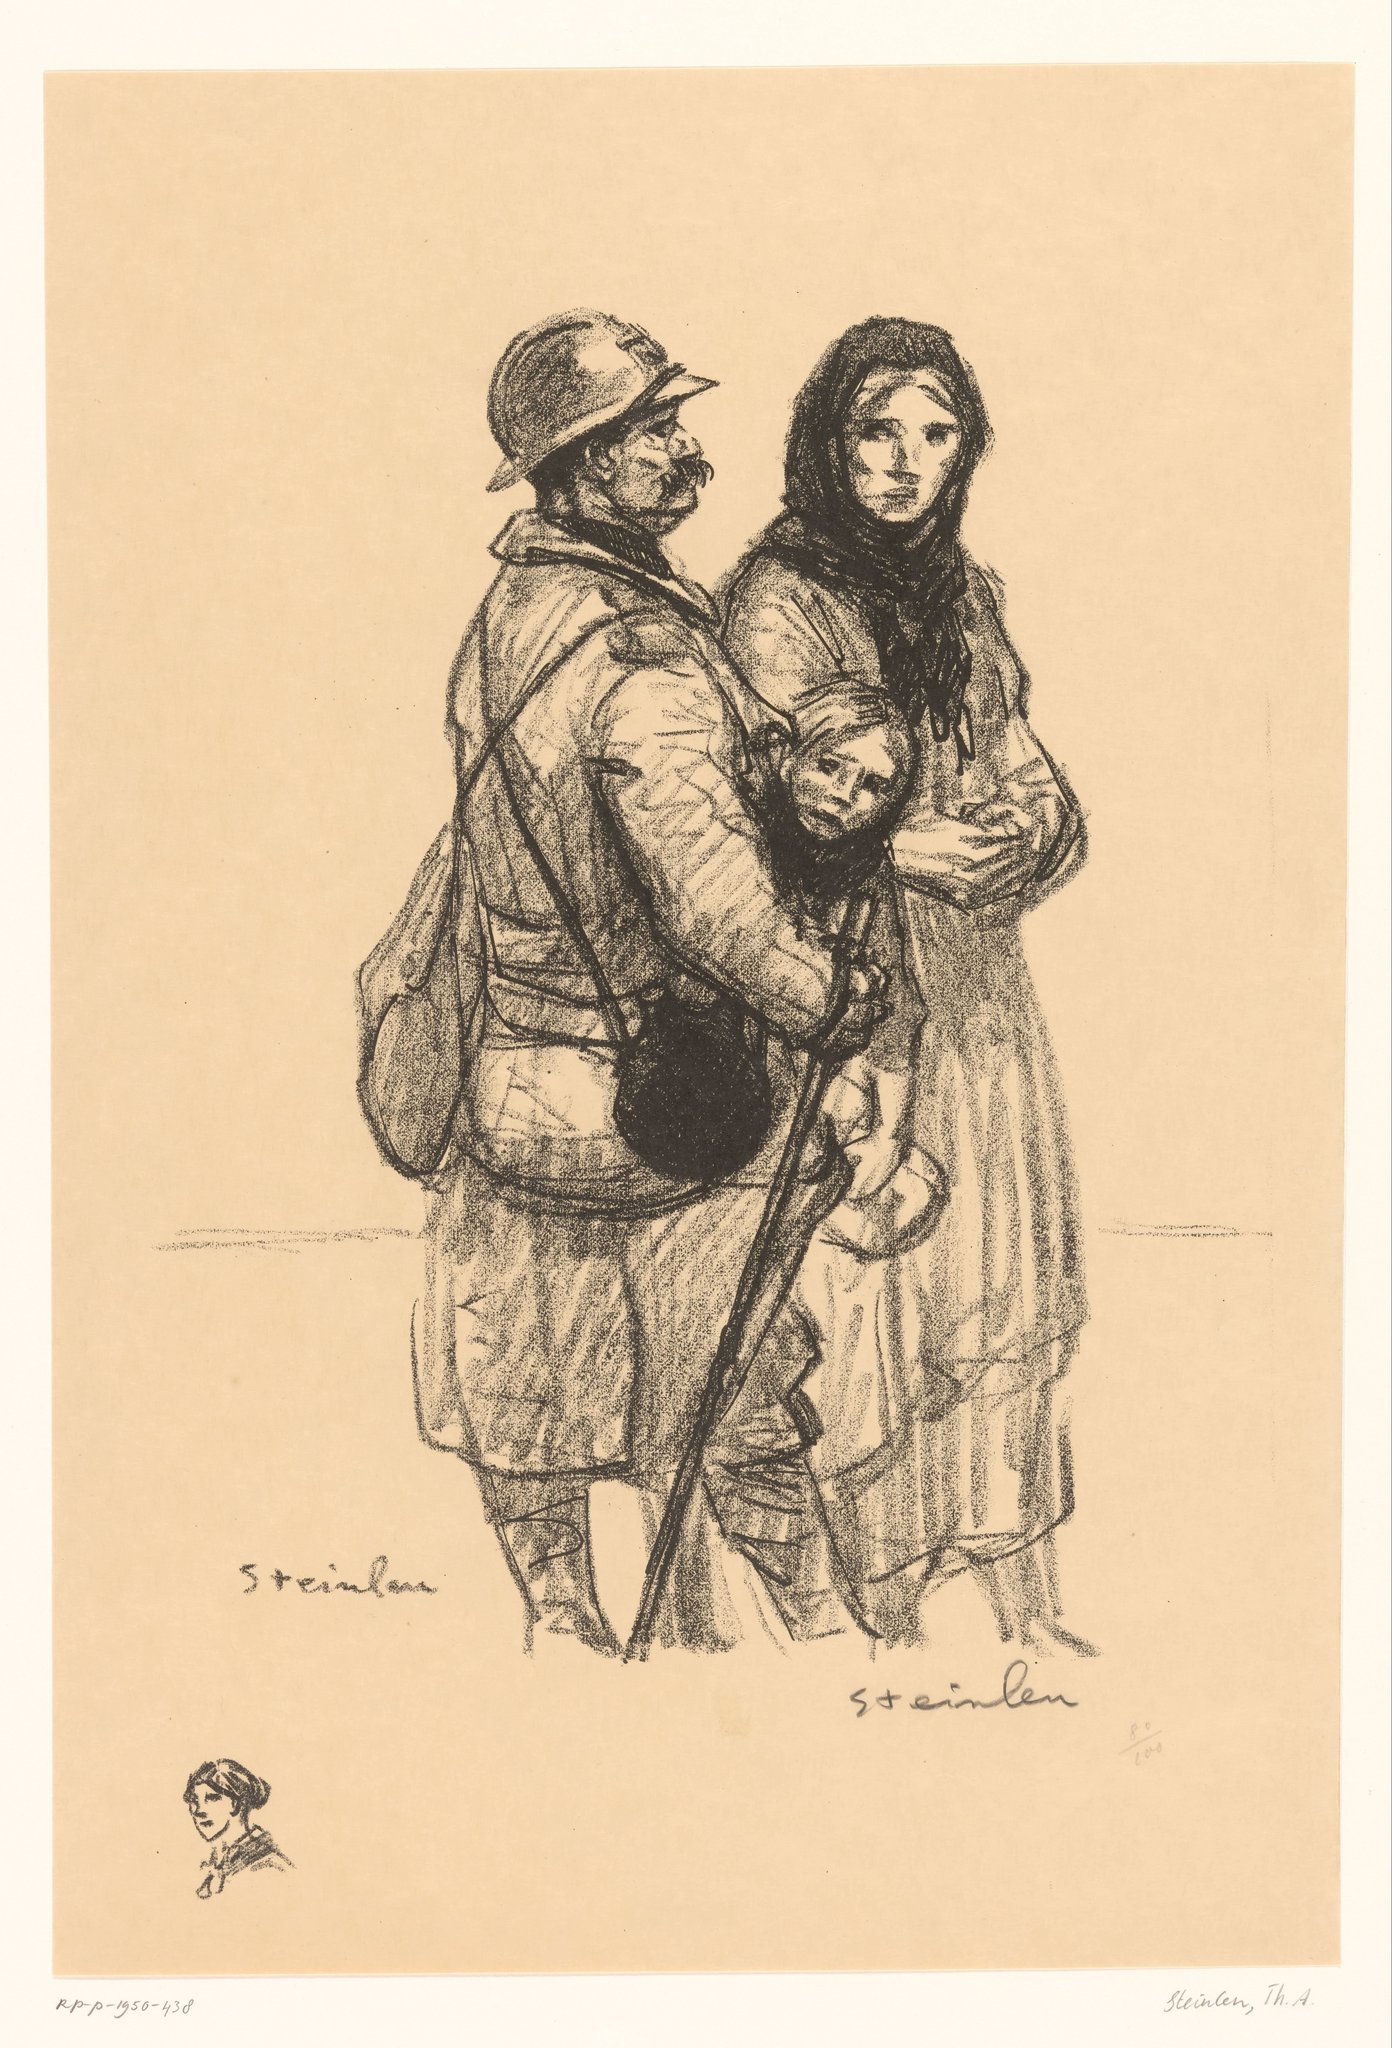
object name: print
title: Soldaat, burgervrouw en kind tijdens de Eerste Wereldoorlog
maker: théophile alexandre steinlen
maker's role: draughtsman, painter, print maker, sculptor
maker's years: 1859-1923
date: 1916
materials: paper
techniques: lithograph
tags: the soldier; the soldier's life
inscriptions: collector's mark: Lugt 2228, signature: ‘Steinlen’